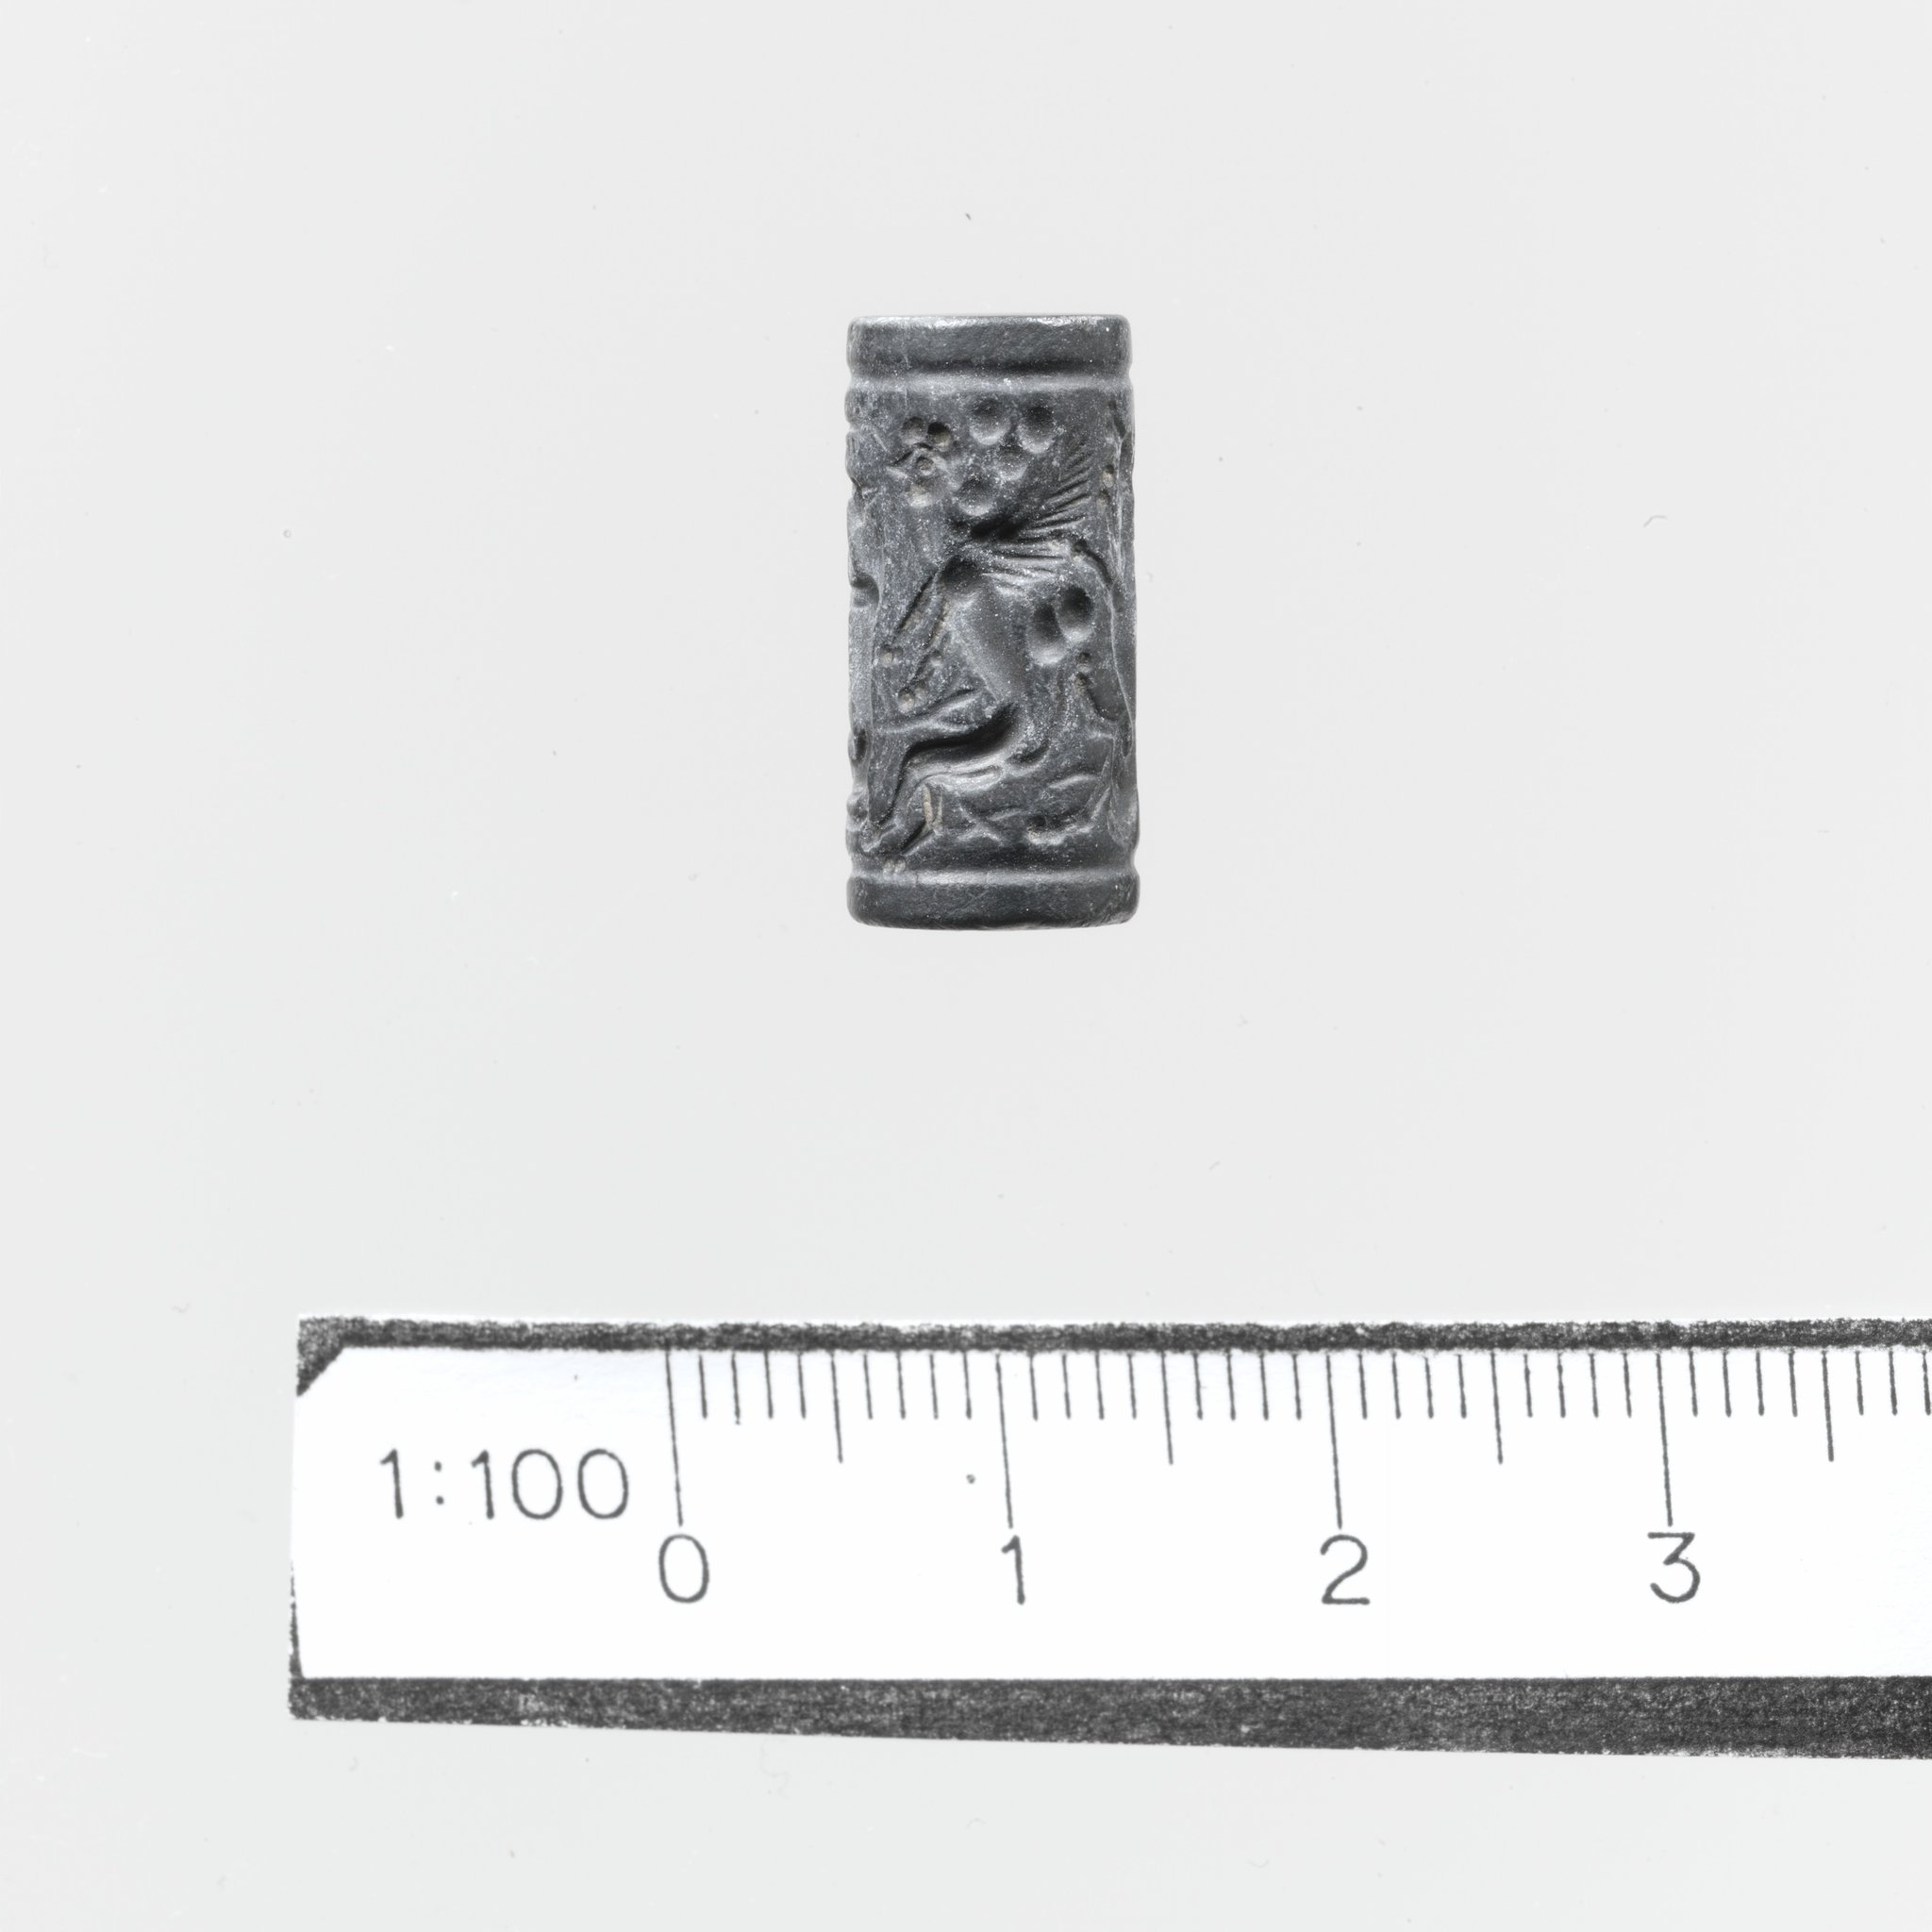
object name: seal, cylinder, animal combat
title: Haematite cylinder seal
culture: minoan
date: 1400-1300 BCE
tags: birds